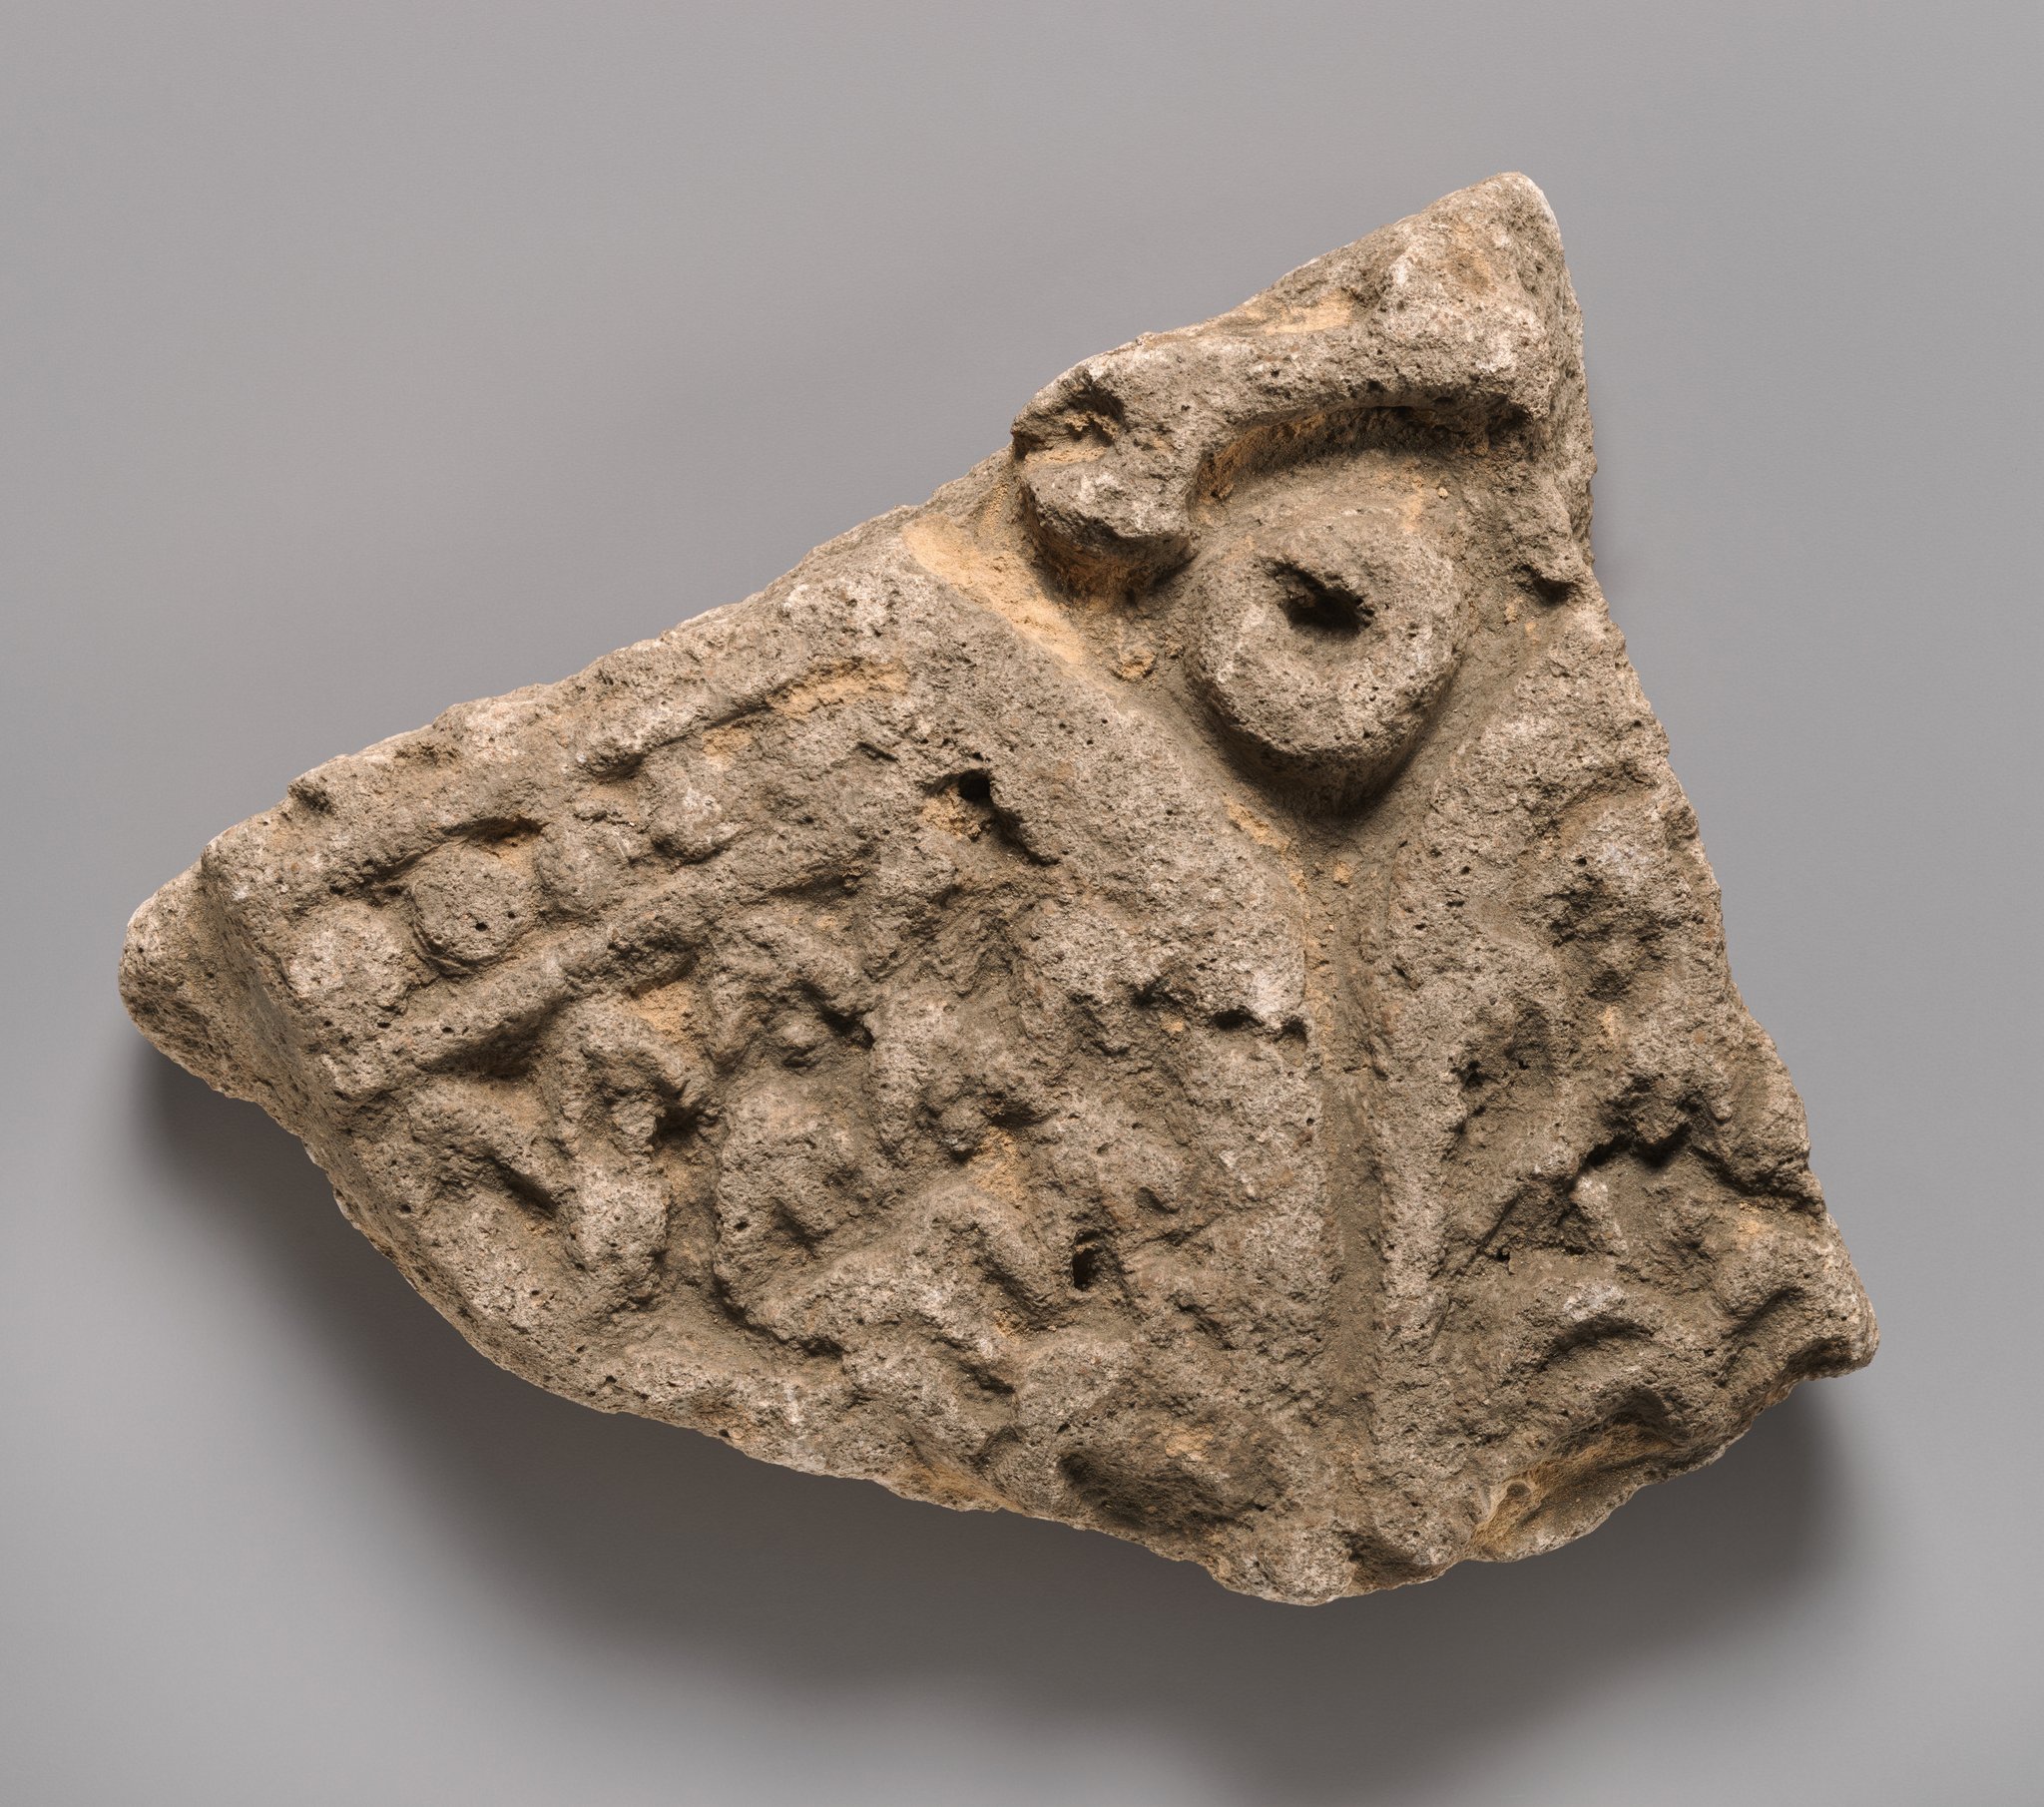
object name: relief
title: Relief fragment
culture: sasanian or islamic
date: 601-700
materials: plaster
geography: mesopotamia